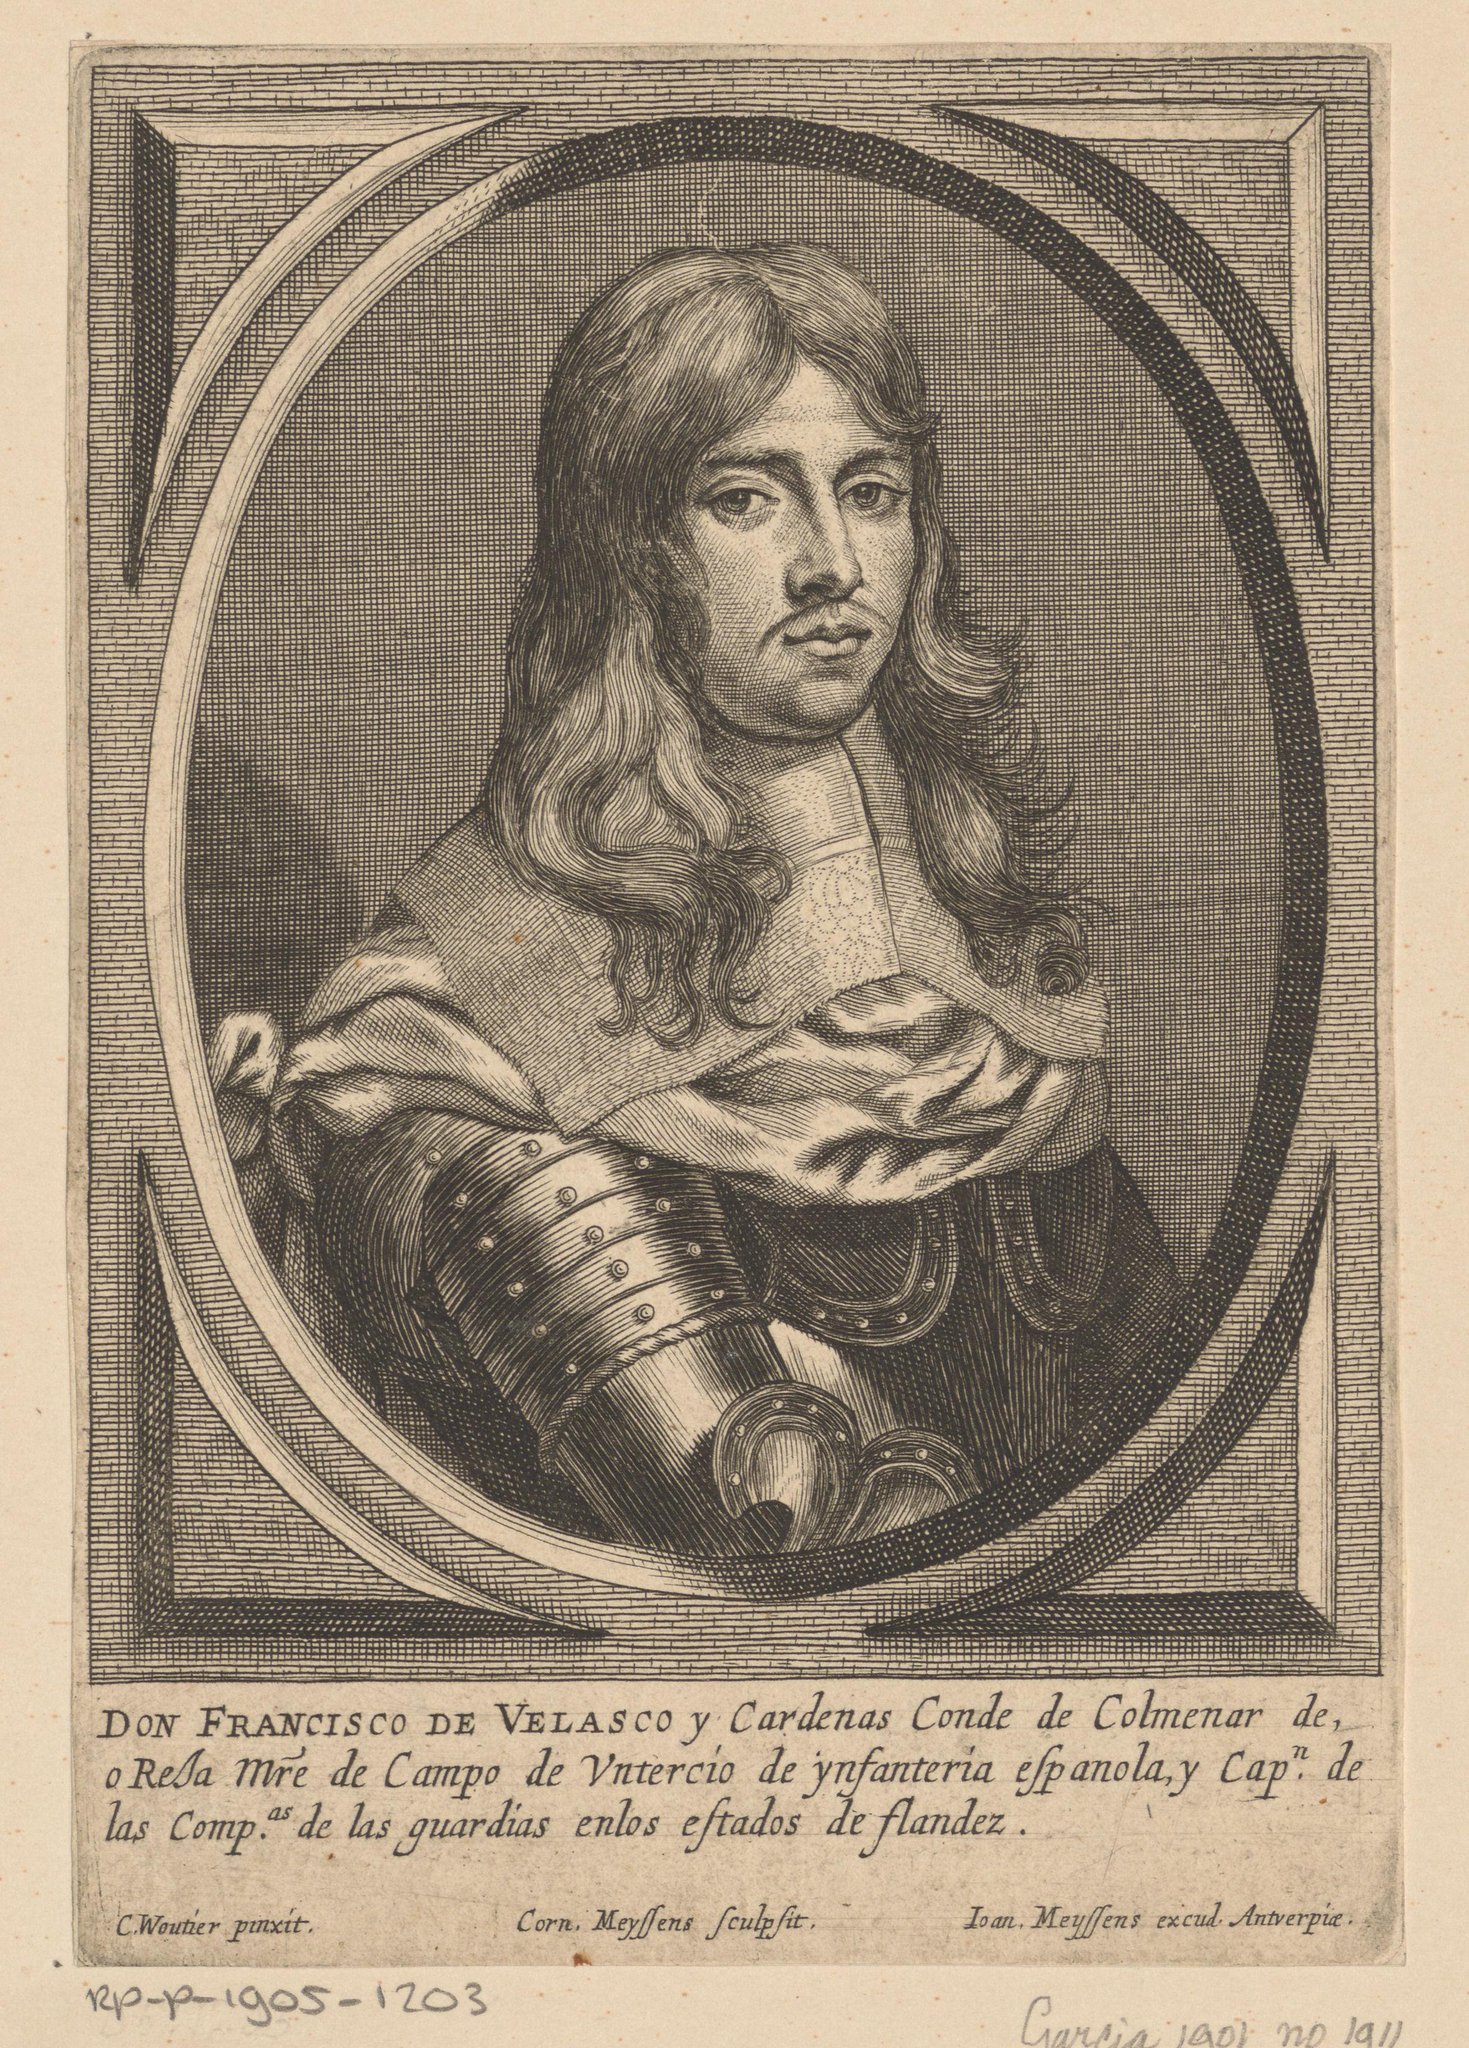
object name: print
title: Portret van Don Francisco Velasco y Cardenas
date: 1650-1670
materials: paper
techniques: engraving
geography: antwerp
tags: armour, historical persons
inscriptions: collector's mark: Lugt 2228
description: Met een drieregelig onderschrift in het Spaans.